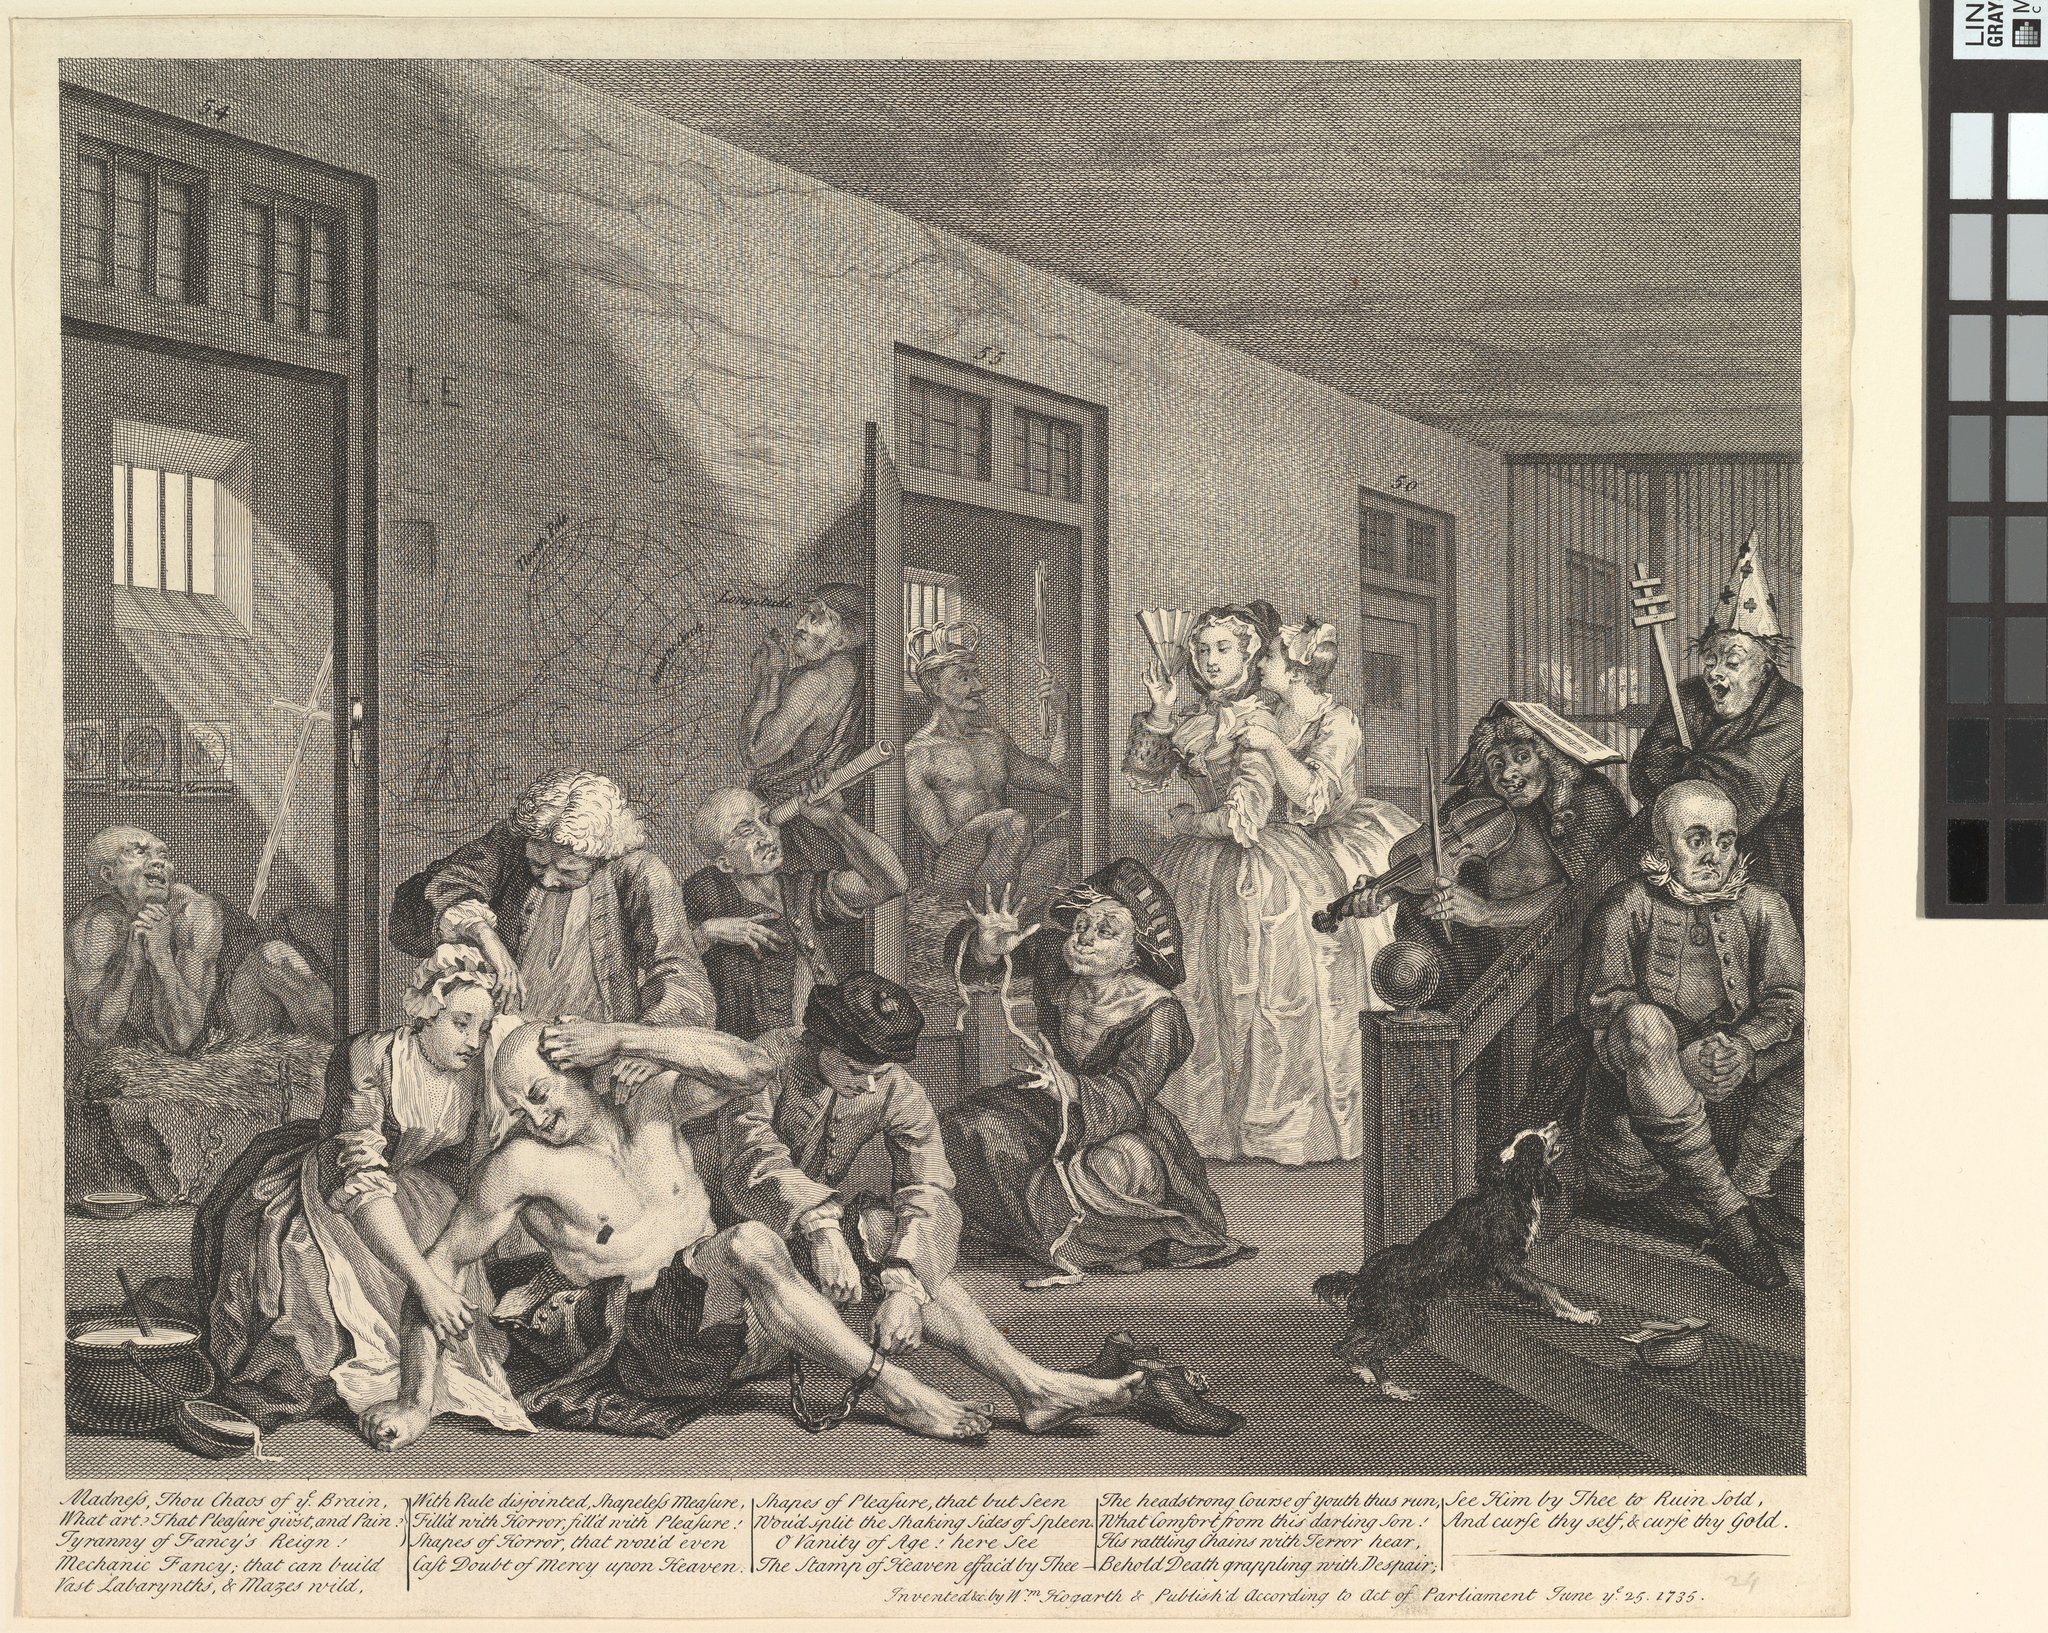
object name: print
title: A Rake's Progress, Plate 8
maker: william hogarth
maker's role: artist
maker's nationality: british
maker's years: 1697-1764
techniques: engraving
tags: men,women,music,violins